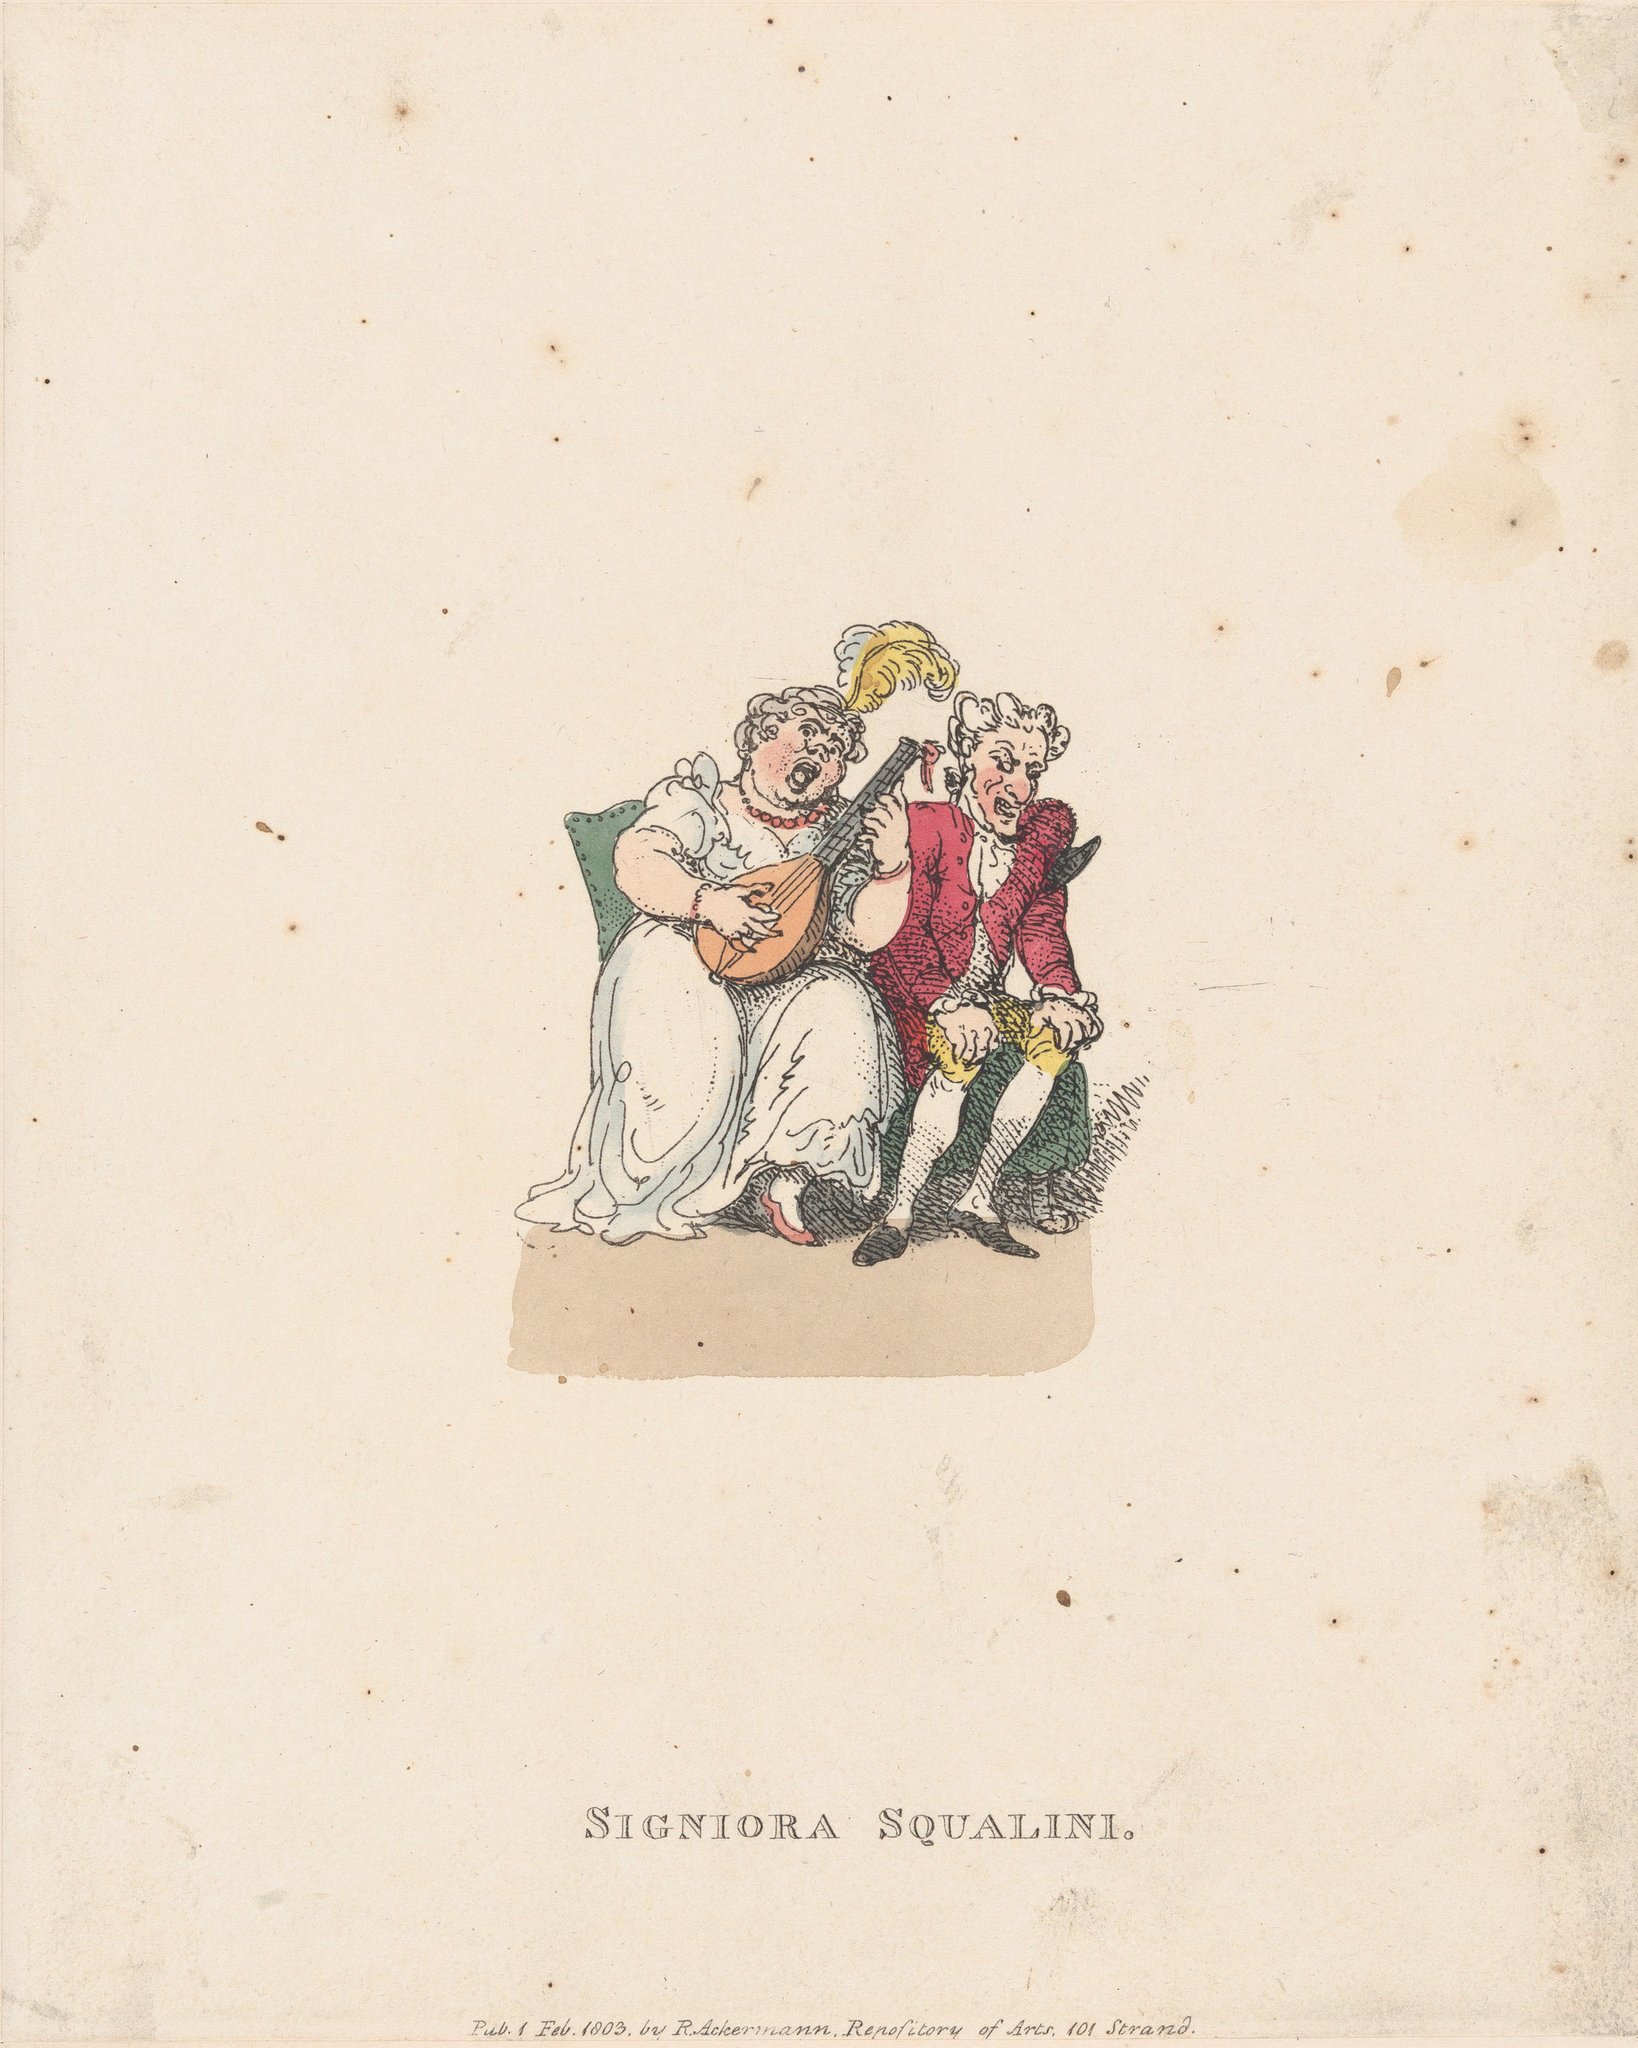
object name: print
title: Signiora Squalini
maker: thomas rowlandson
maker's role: artist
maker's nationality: british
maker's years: 1757-1827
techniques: etching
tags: musical instruments,satire,men,women,musicians